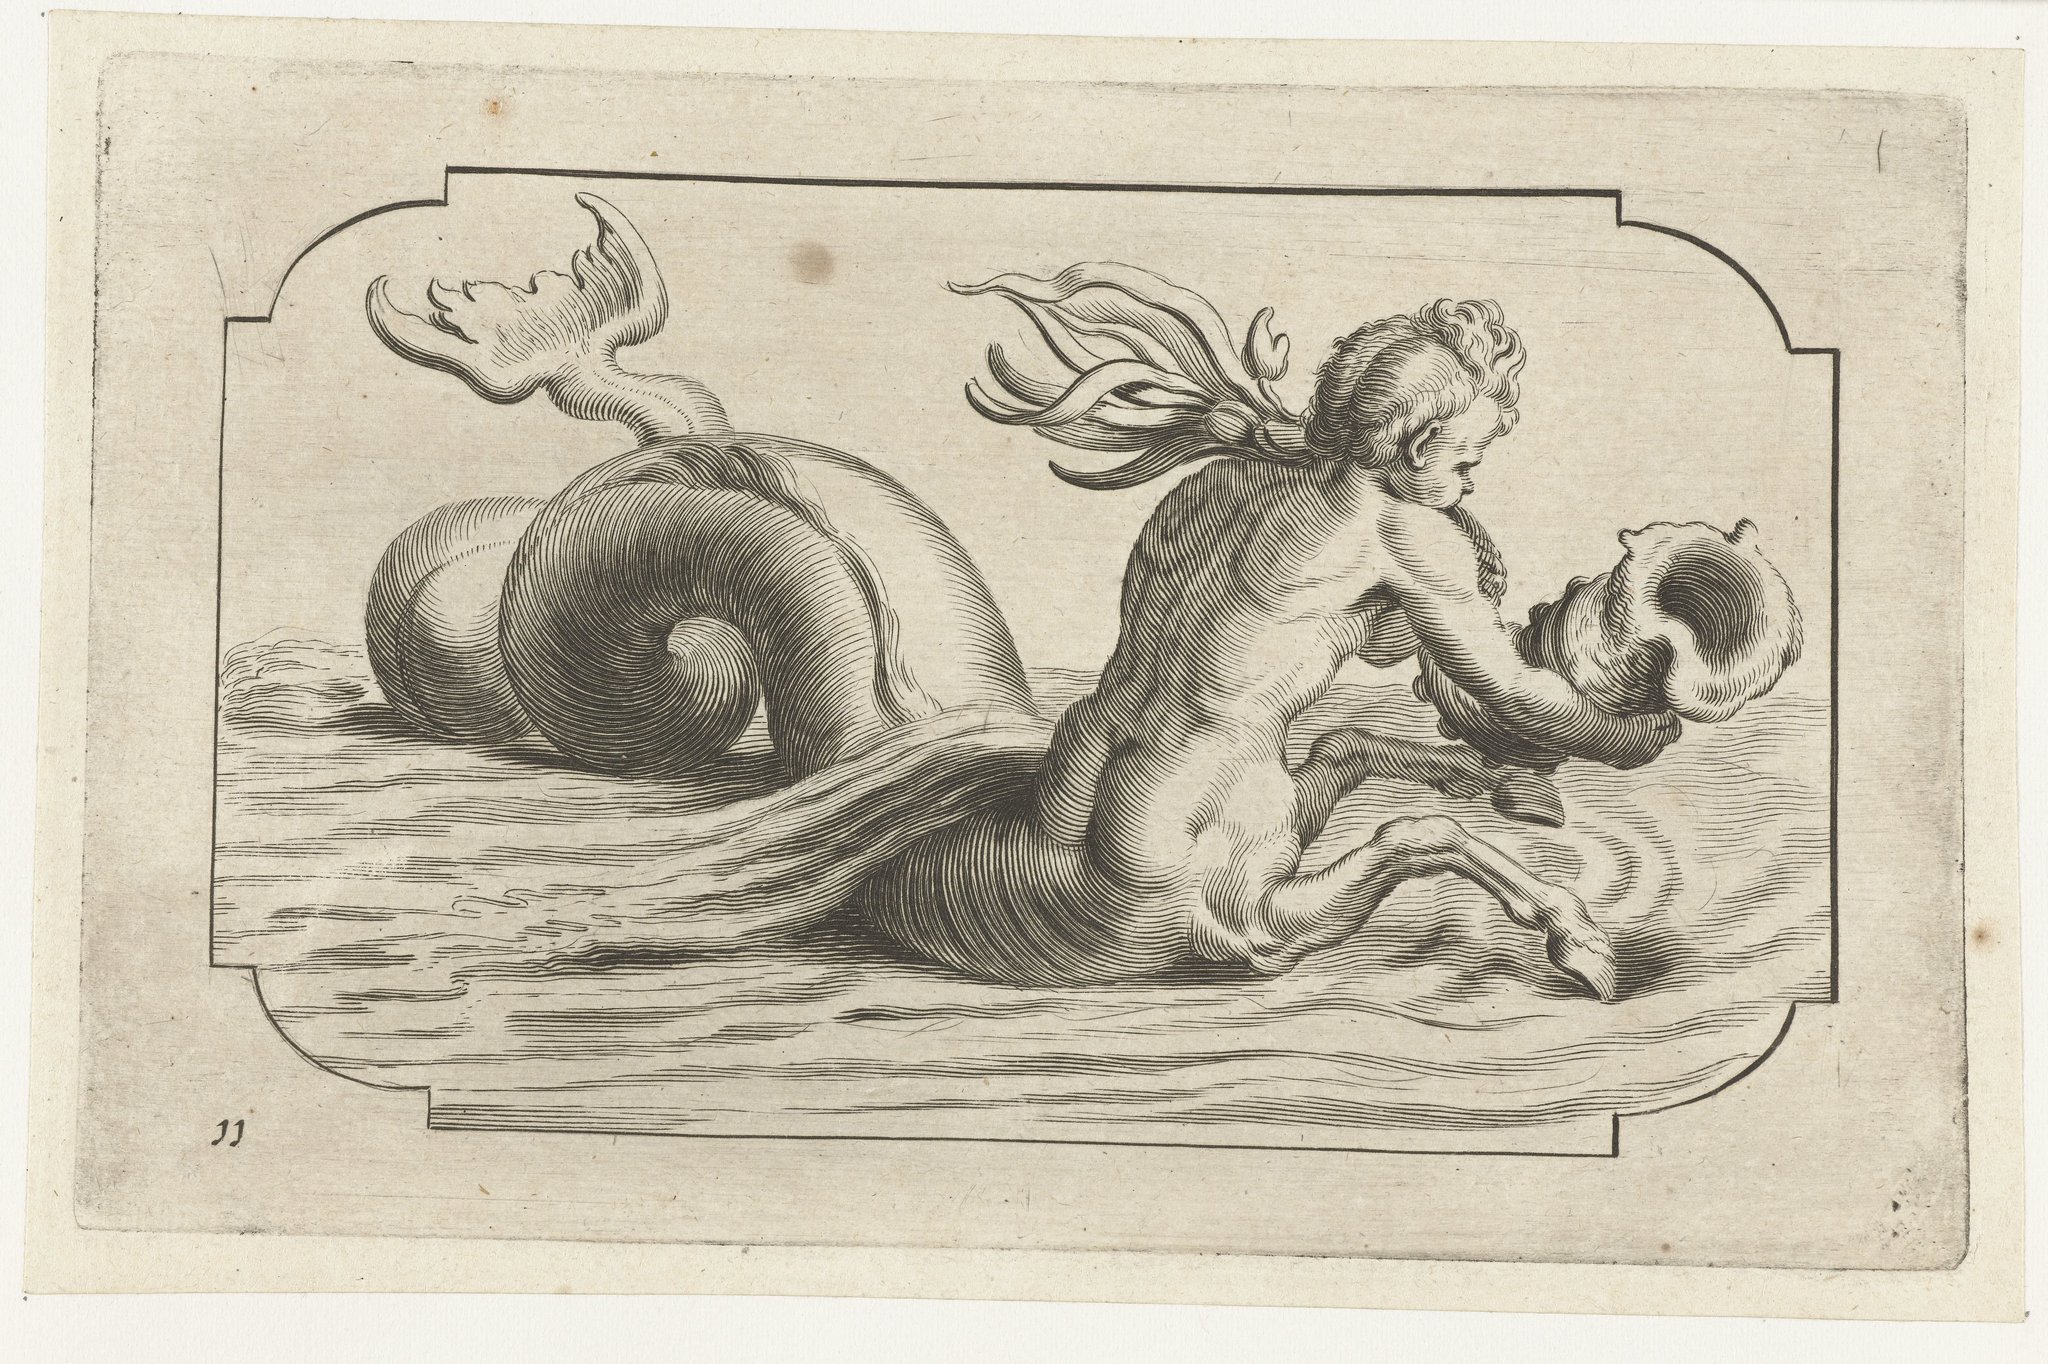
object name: print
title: Zeepaard met een mannelijk bovenlichaam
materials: paper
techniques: engraving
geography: amsterdam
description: Een zeepaard met mannelijk bovenlichaam blaast op een schelp.